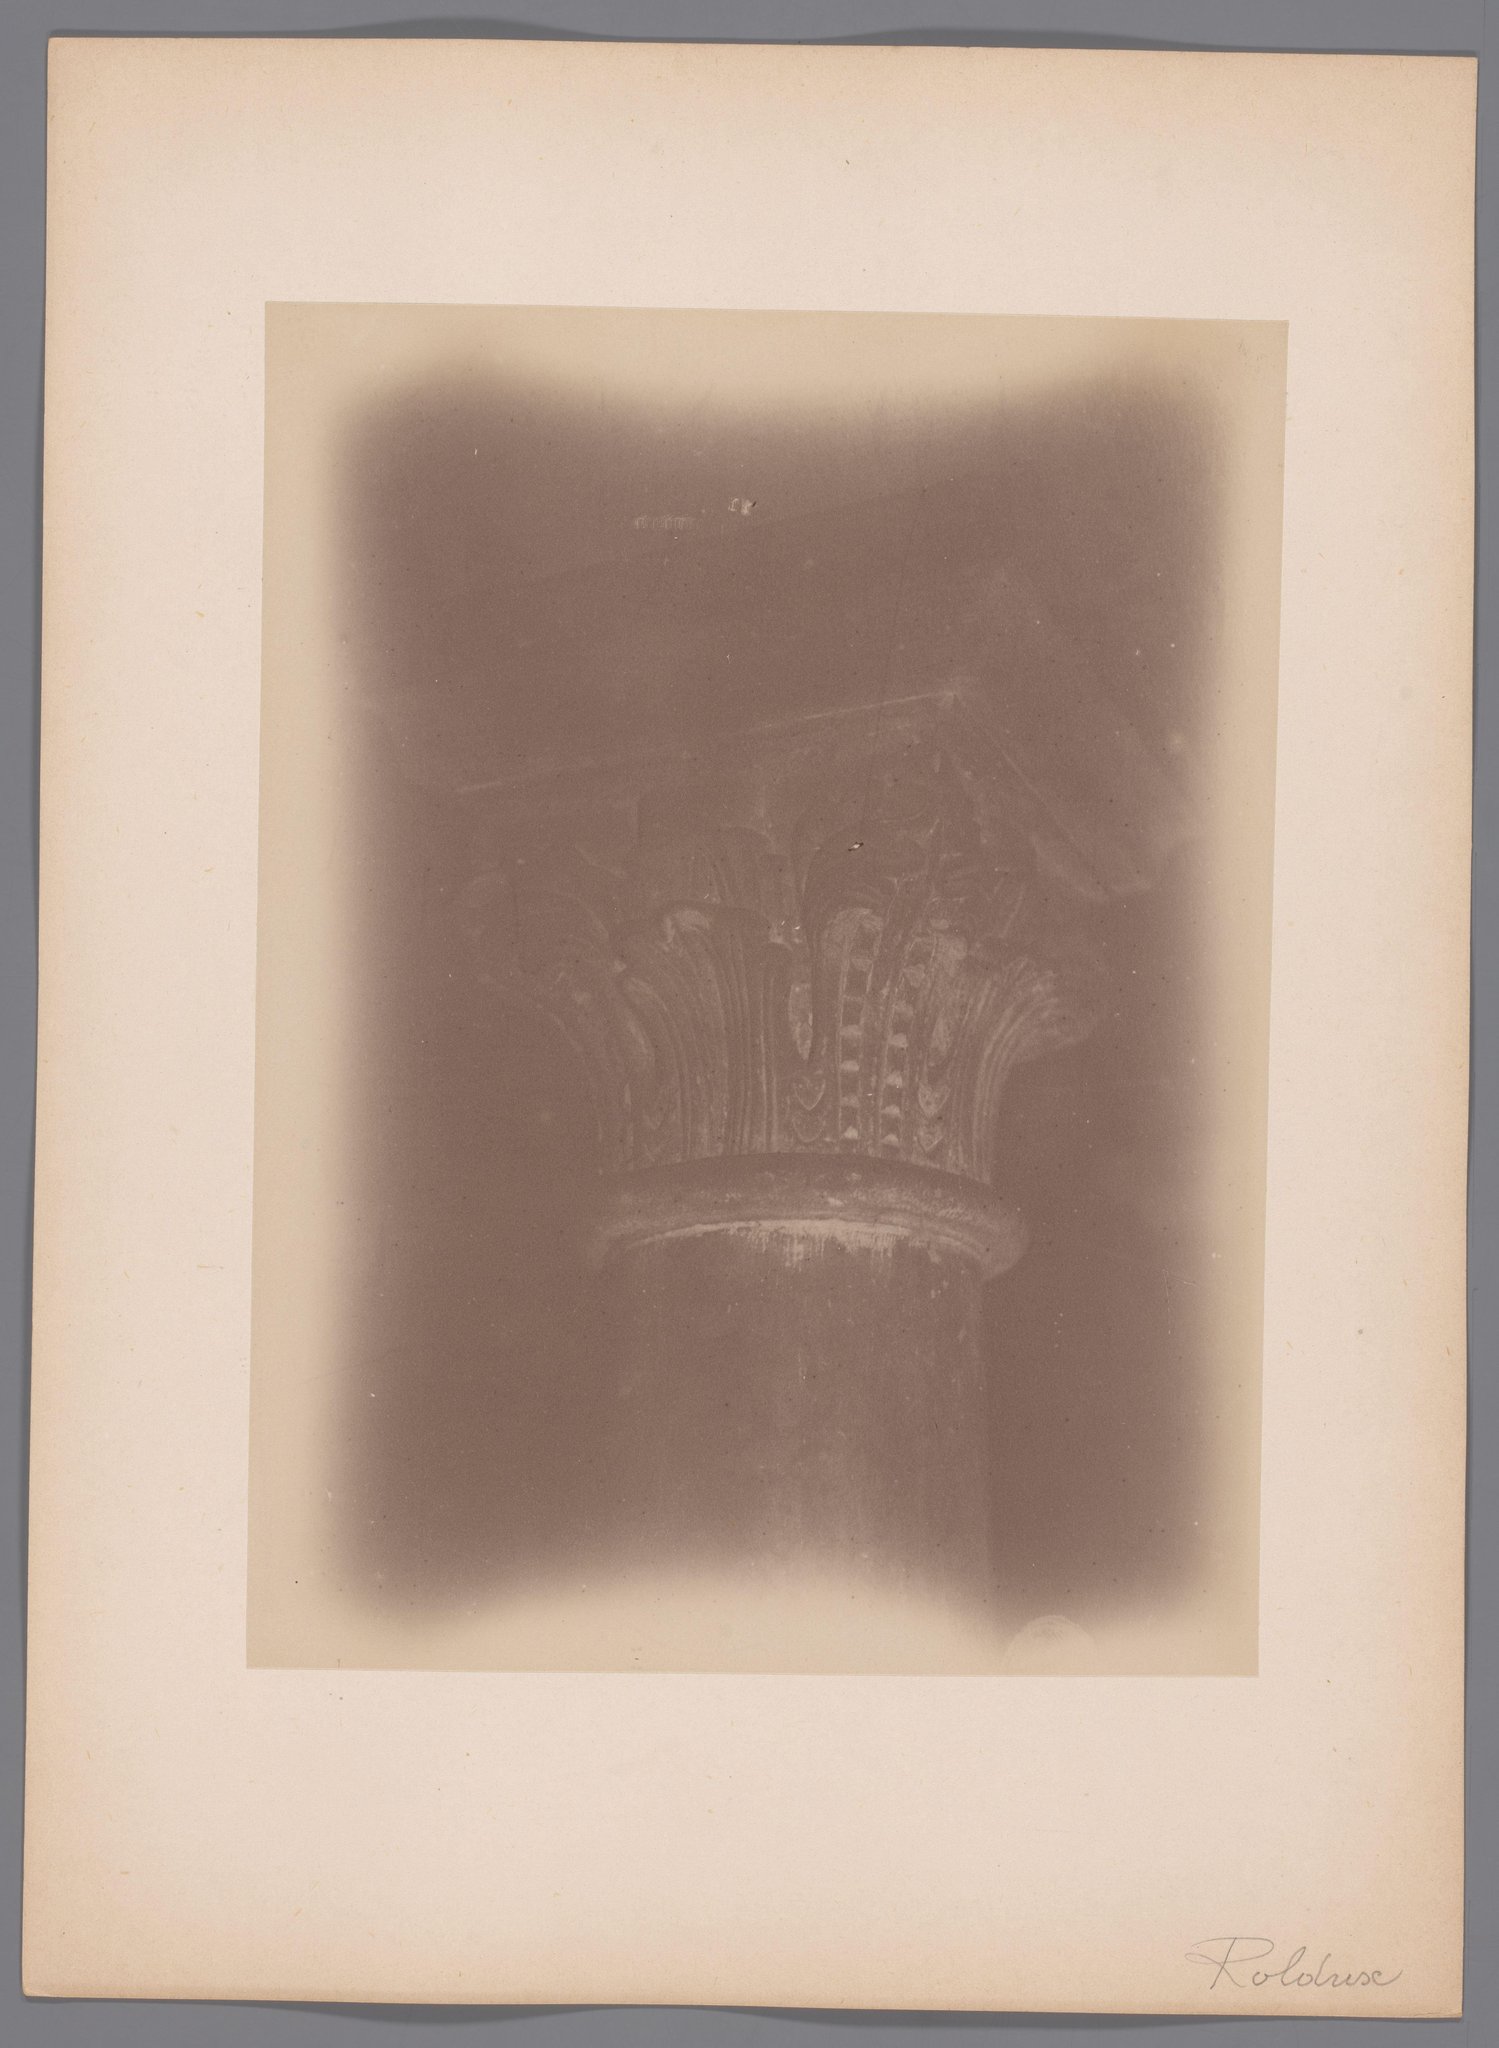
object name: photograph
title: Kapiteel van een kolom in crypte van de Abdijkerk te Rolduc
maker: anoniem (monumentenzorg)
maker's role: fotograaf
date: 1890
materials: cardboard, photographic support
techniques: albumen print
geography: rolduc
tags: capital (~ column, pillar), parts of church interior (crypt)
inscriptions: annotation: ‘Kapiteel van een der kolommen in de Krypte der kerk te Rolduc/ oct 1980’, annotation: ‘Rolduc’